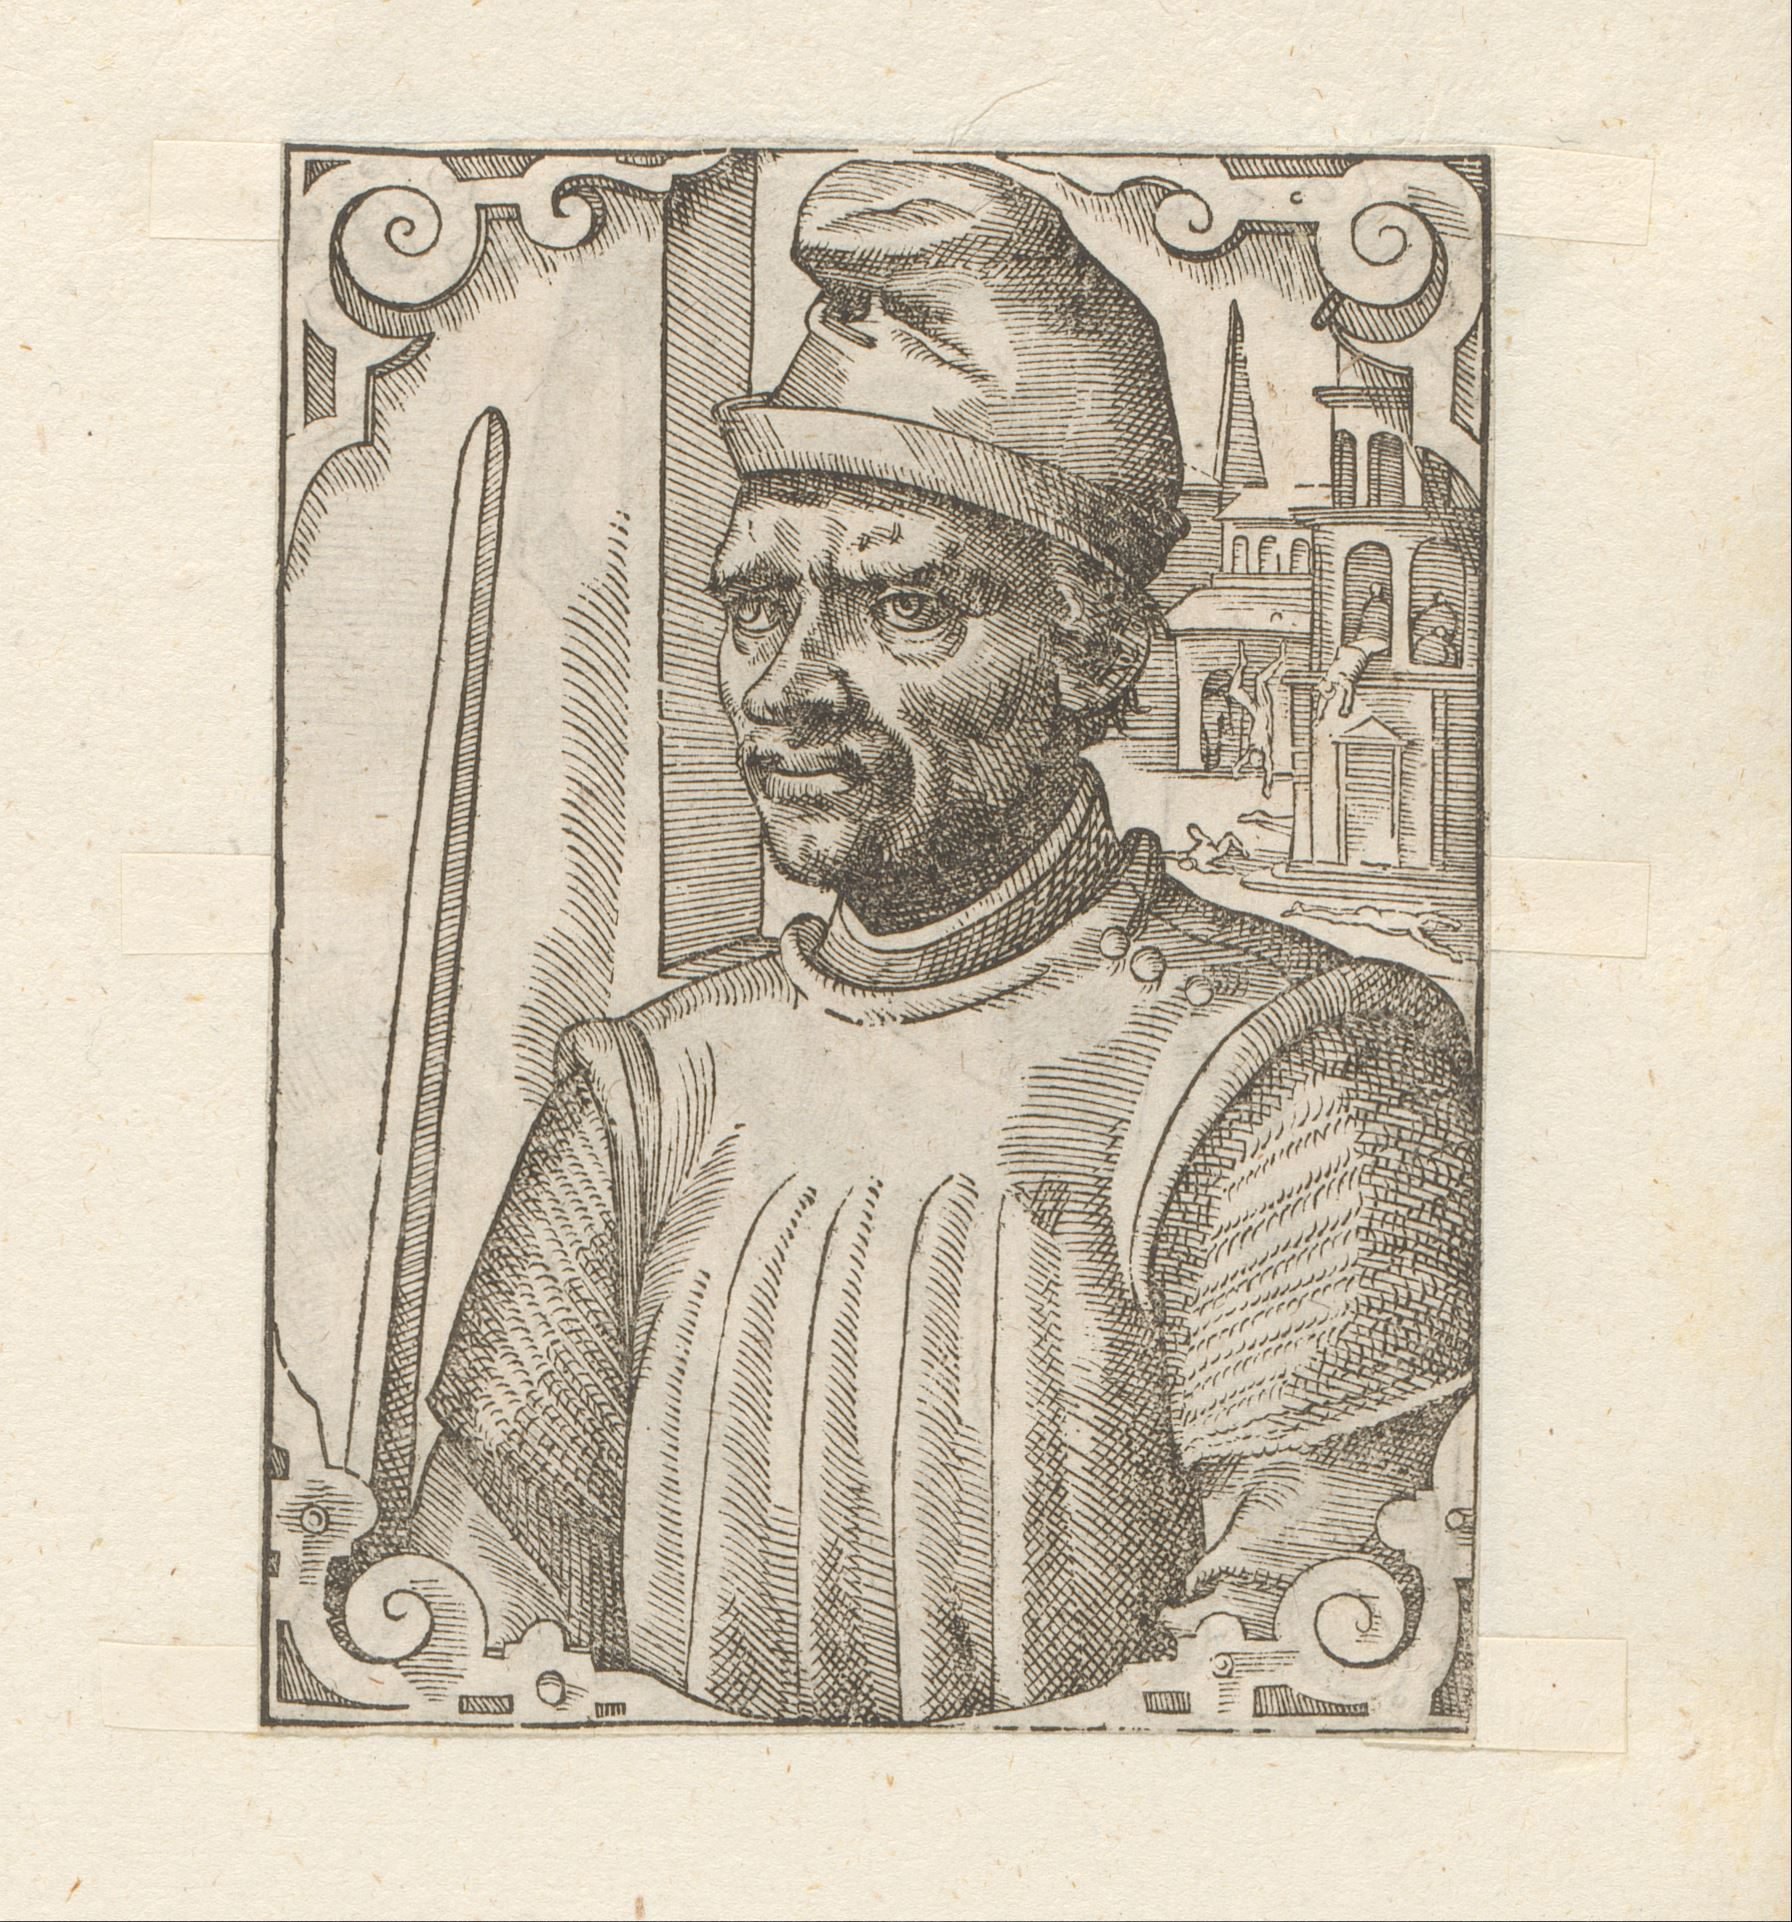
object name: album leaf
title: Portret van Cabrinus Fondalius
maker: Anonymous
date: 1549-1577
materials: paper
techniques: woodcut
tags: historical persons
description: Prent gebruikt in: Giovio, Paolo. Musaei Ioviani Imagines (...). Bazel: Peter Perna, 1577.